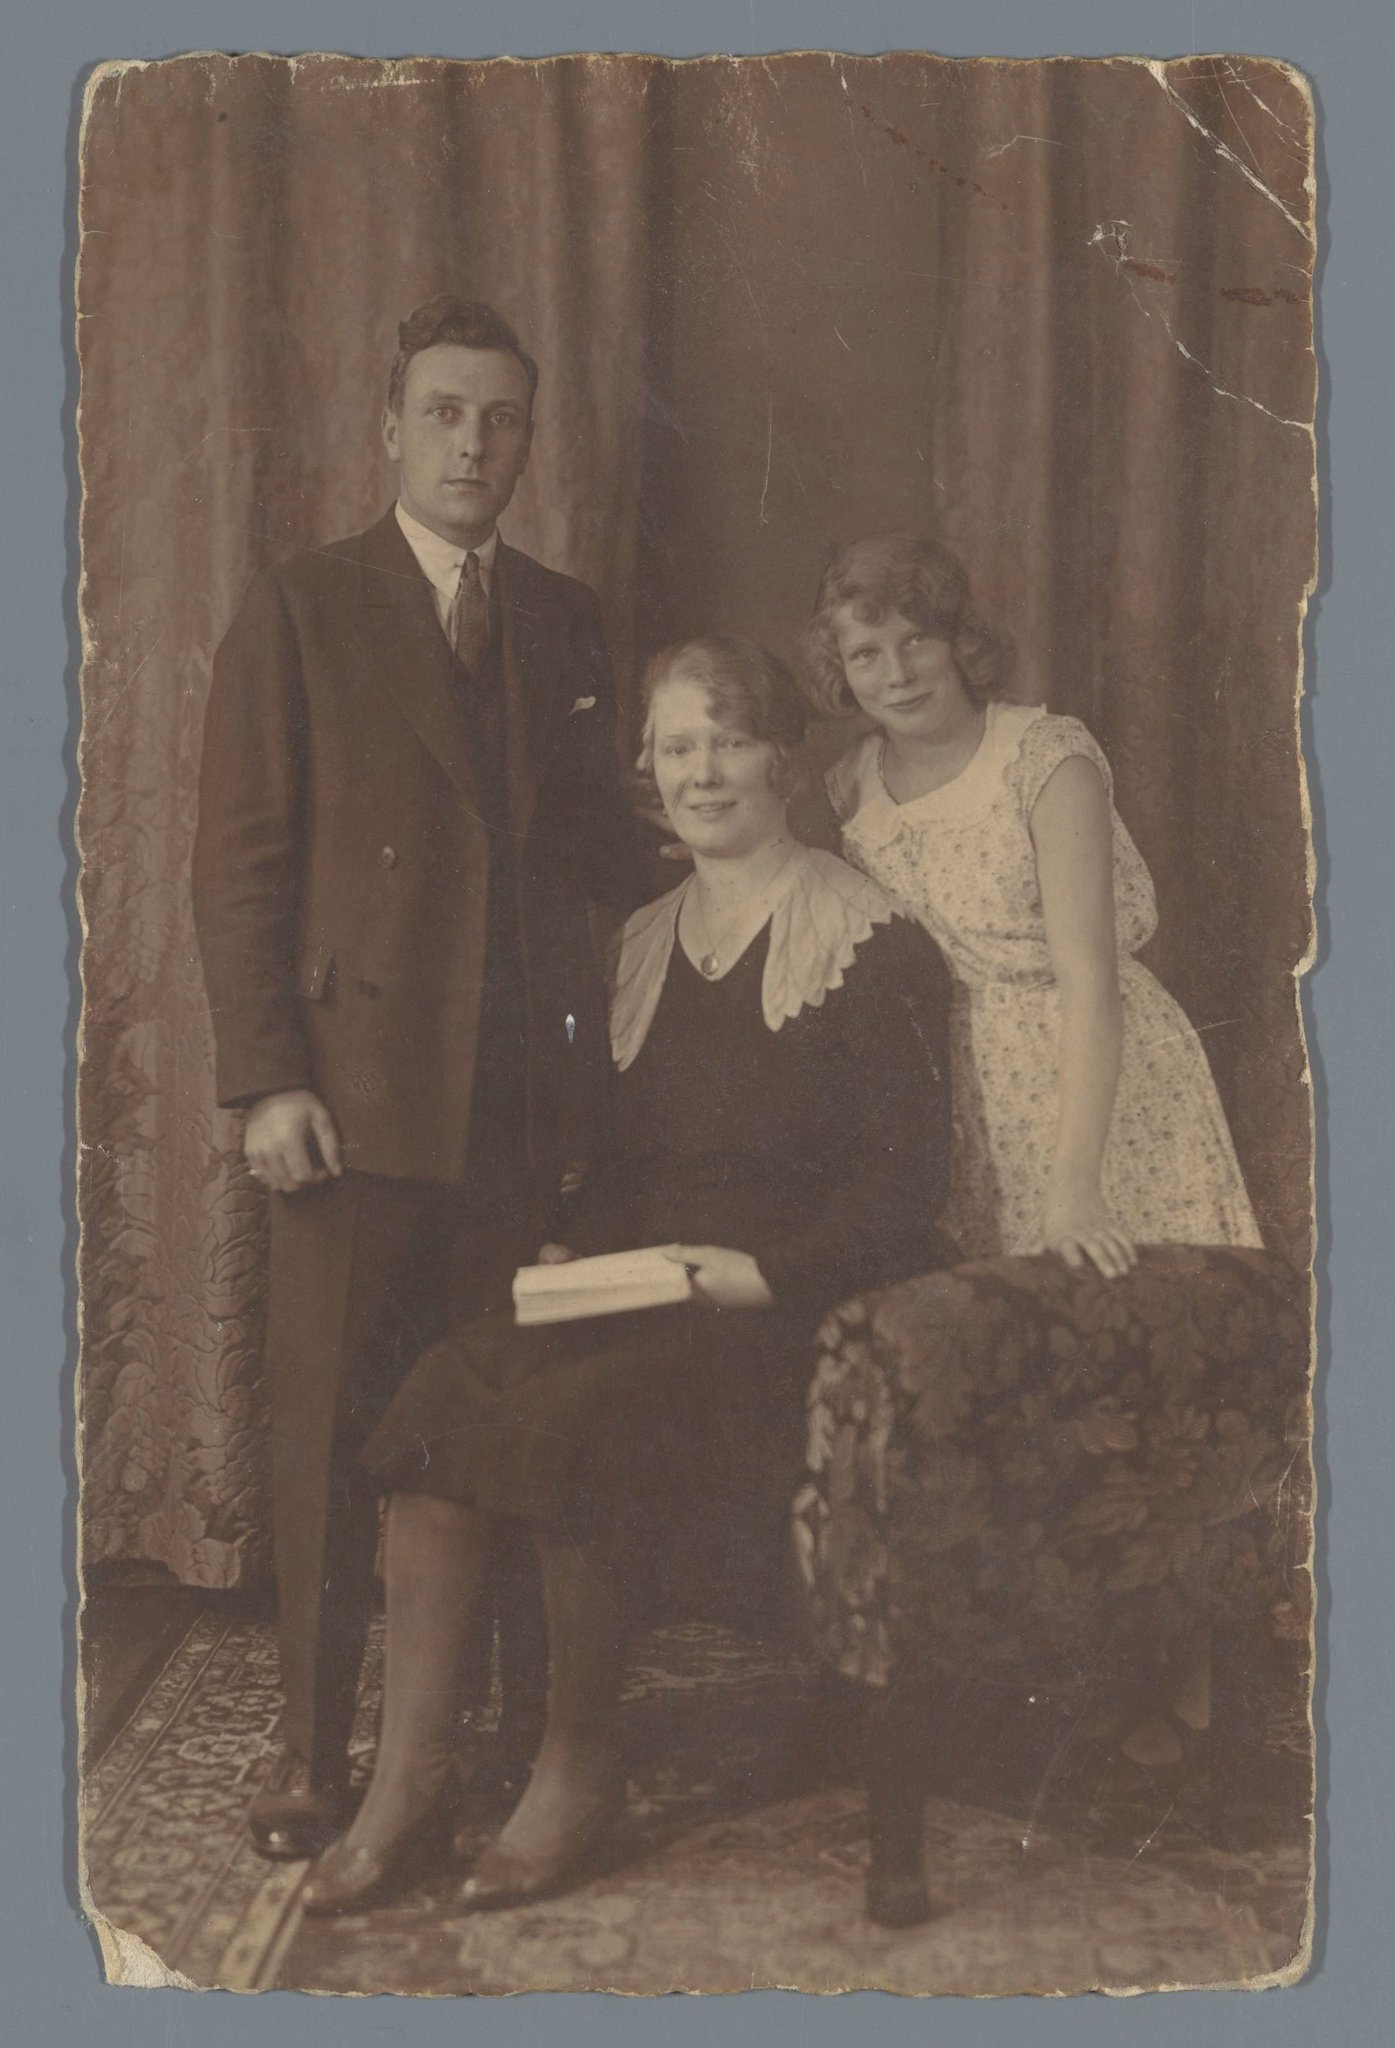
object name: photograph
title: Portret van een onbekende man en vrouw en hun dochter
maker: Anonymous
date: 1905-1920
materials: photographic support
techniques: gelatin silver print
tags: father and child(ren), man and child(ren) (family group)